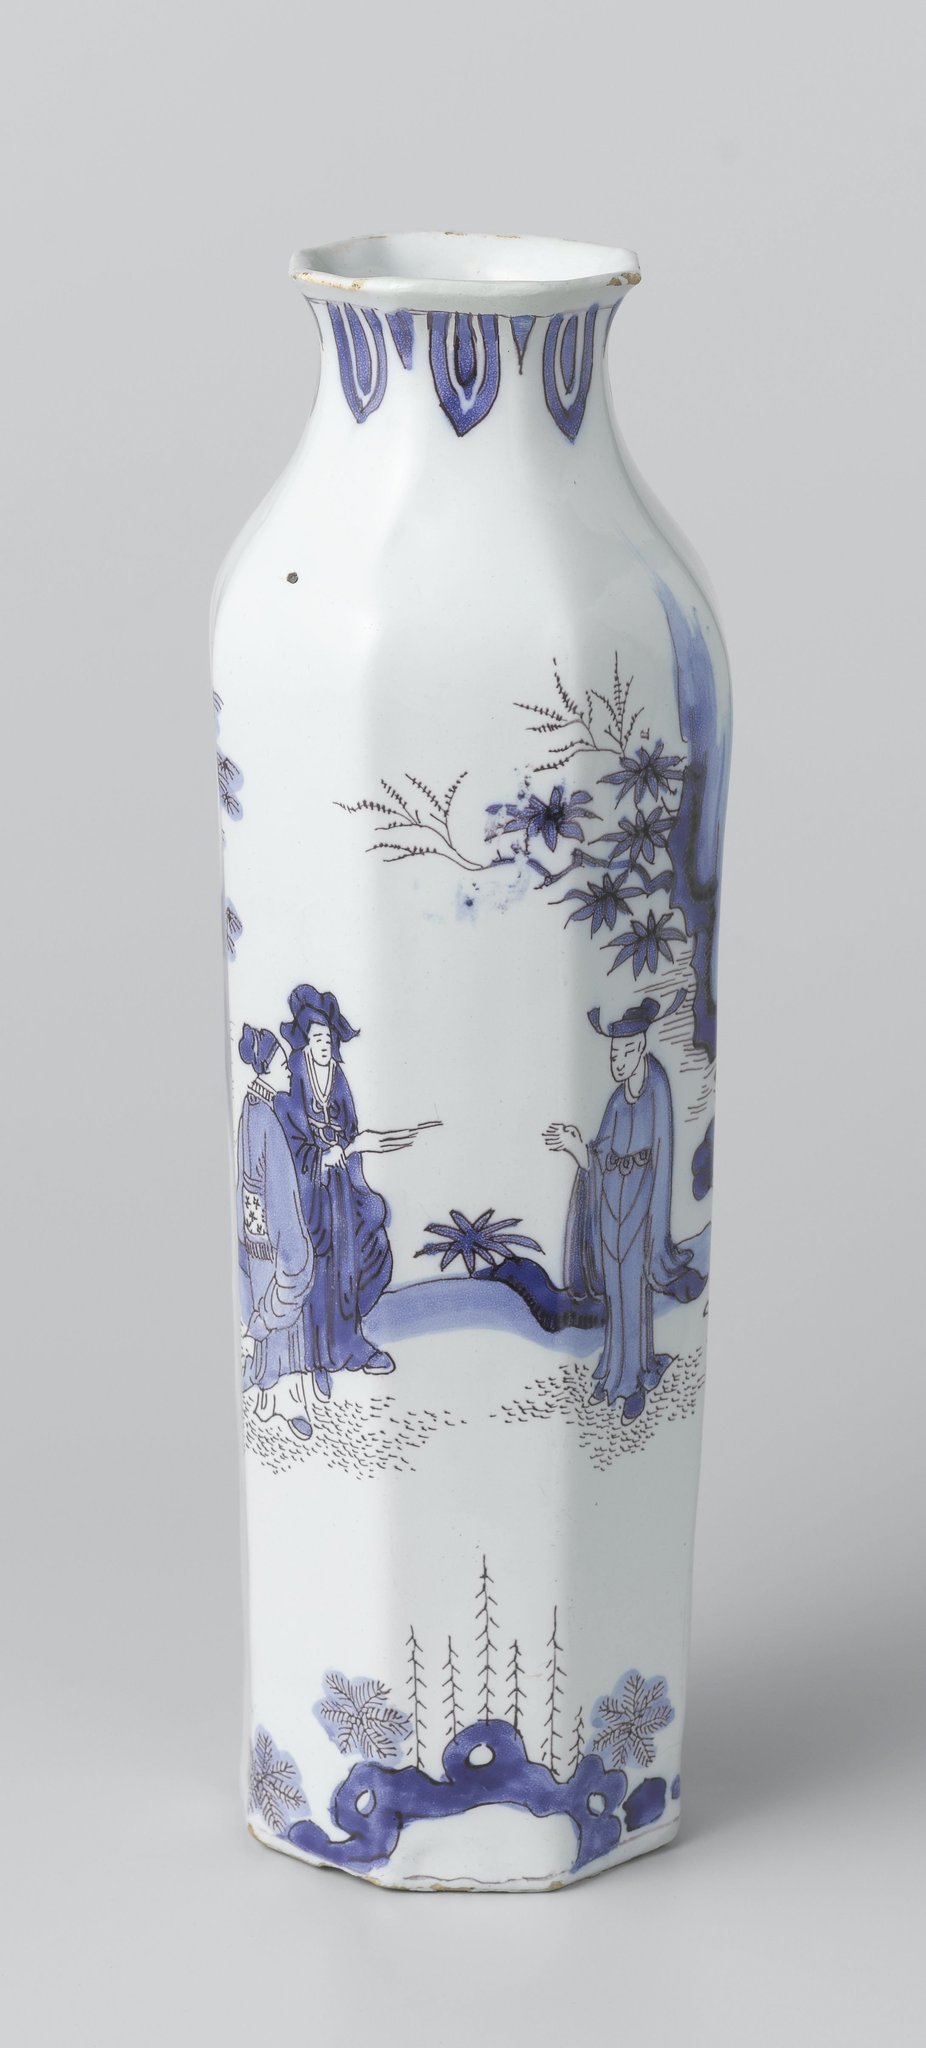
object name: vase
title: Two vases (rolwagens or sleeve vases)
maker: Anonymous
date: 1660-1685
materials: earthenware, glaze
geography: delft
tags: chinese (+ other cultural aspects)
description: Vaas van faience met een decoratie naar het Chinese porselein uit de overgangsperiode.